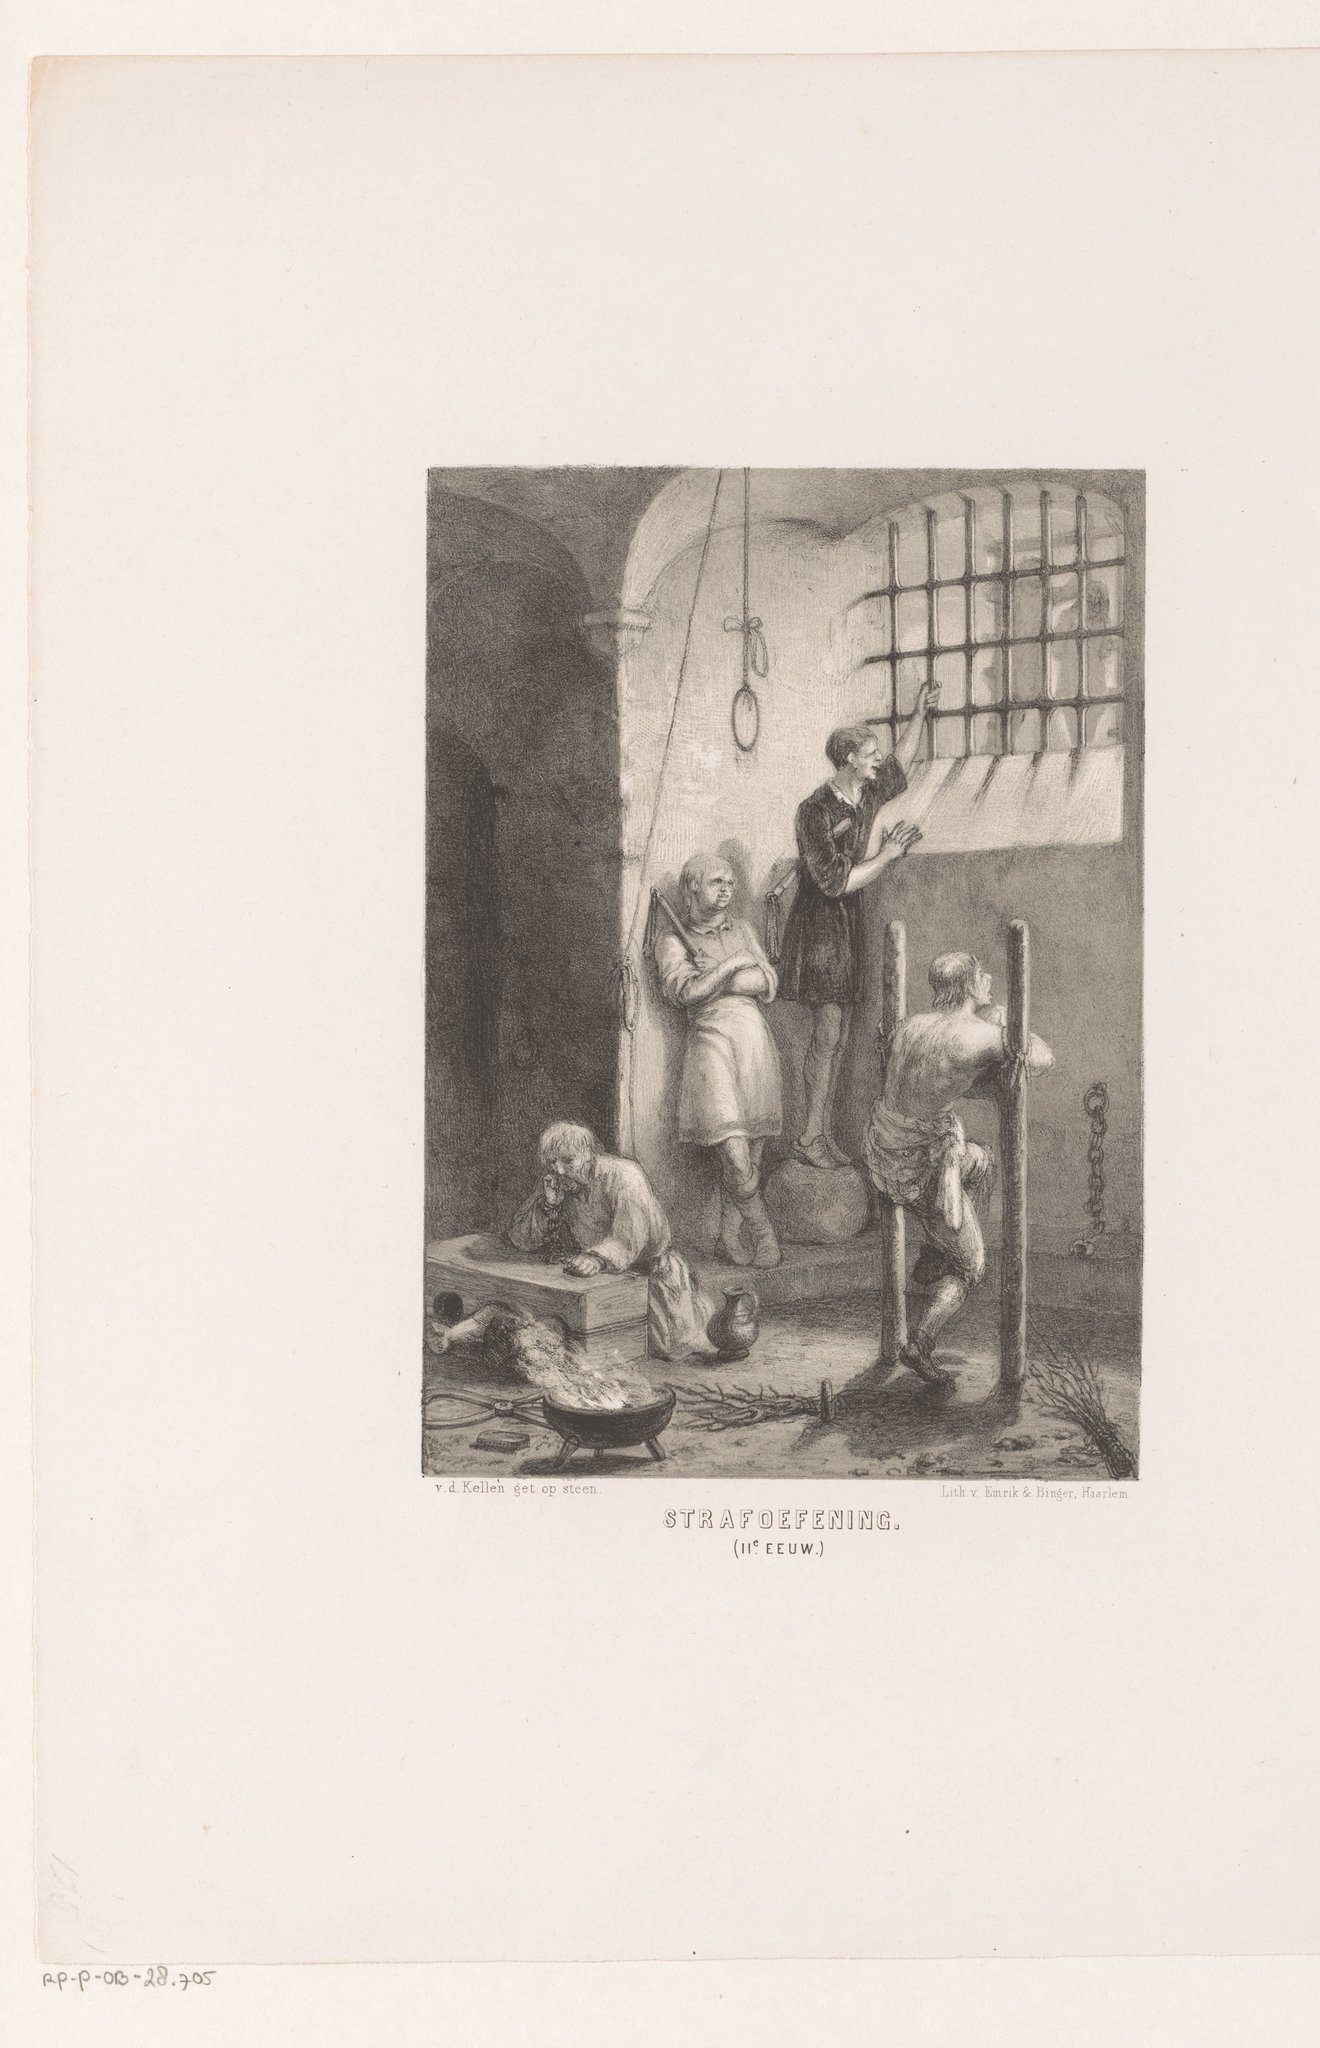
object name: print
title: Strafoefening. (11e eeuw)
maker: david van der kellen (1827-1895)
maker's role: draughtsman, print maker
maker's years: 1827-1895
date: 1857-1864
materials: paper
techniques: tone lithography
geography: haarlem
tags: prison, jail, instruments of torture, execution or punishment, netherlands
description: Twee geketende gevangenen en twee beulen met martelwerktuigen in een gevangenis in de 11e eeuw. Rechts een venster naar de straat.